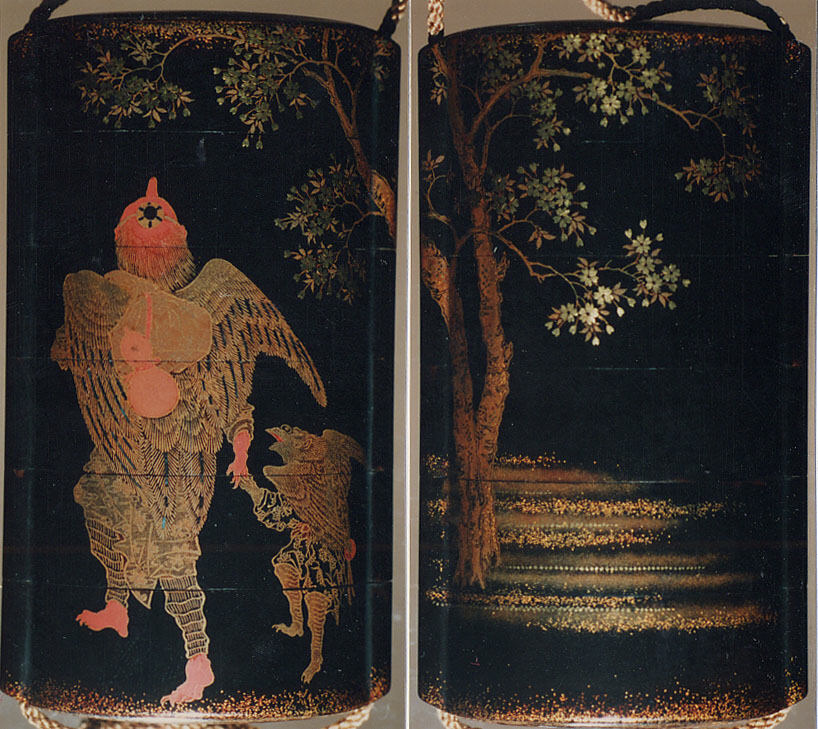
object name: inrō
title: Case (Inrō) with Design of Two Tengu (Goblins) with Knapsack and Gourd, under a Cherry Tree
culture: japanese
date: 1701-1900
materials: foil, gold, lacquer, silver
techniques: fundame, roiro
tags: mythical creatures,trees